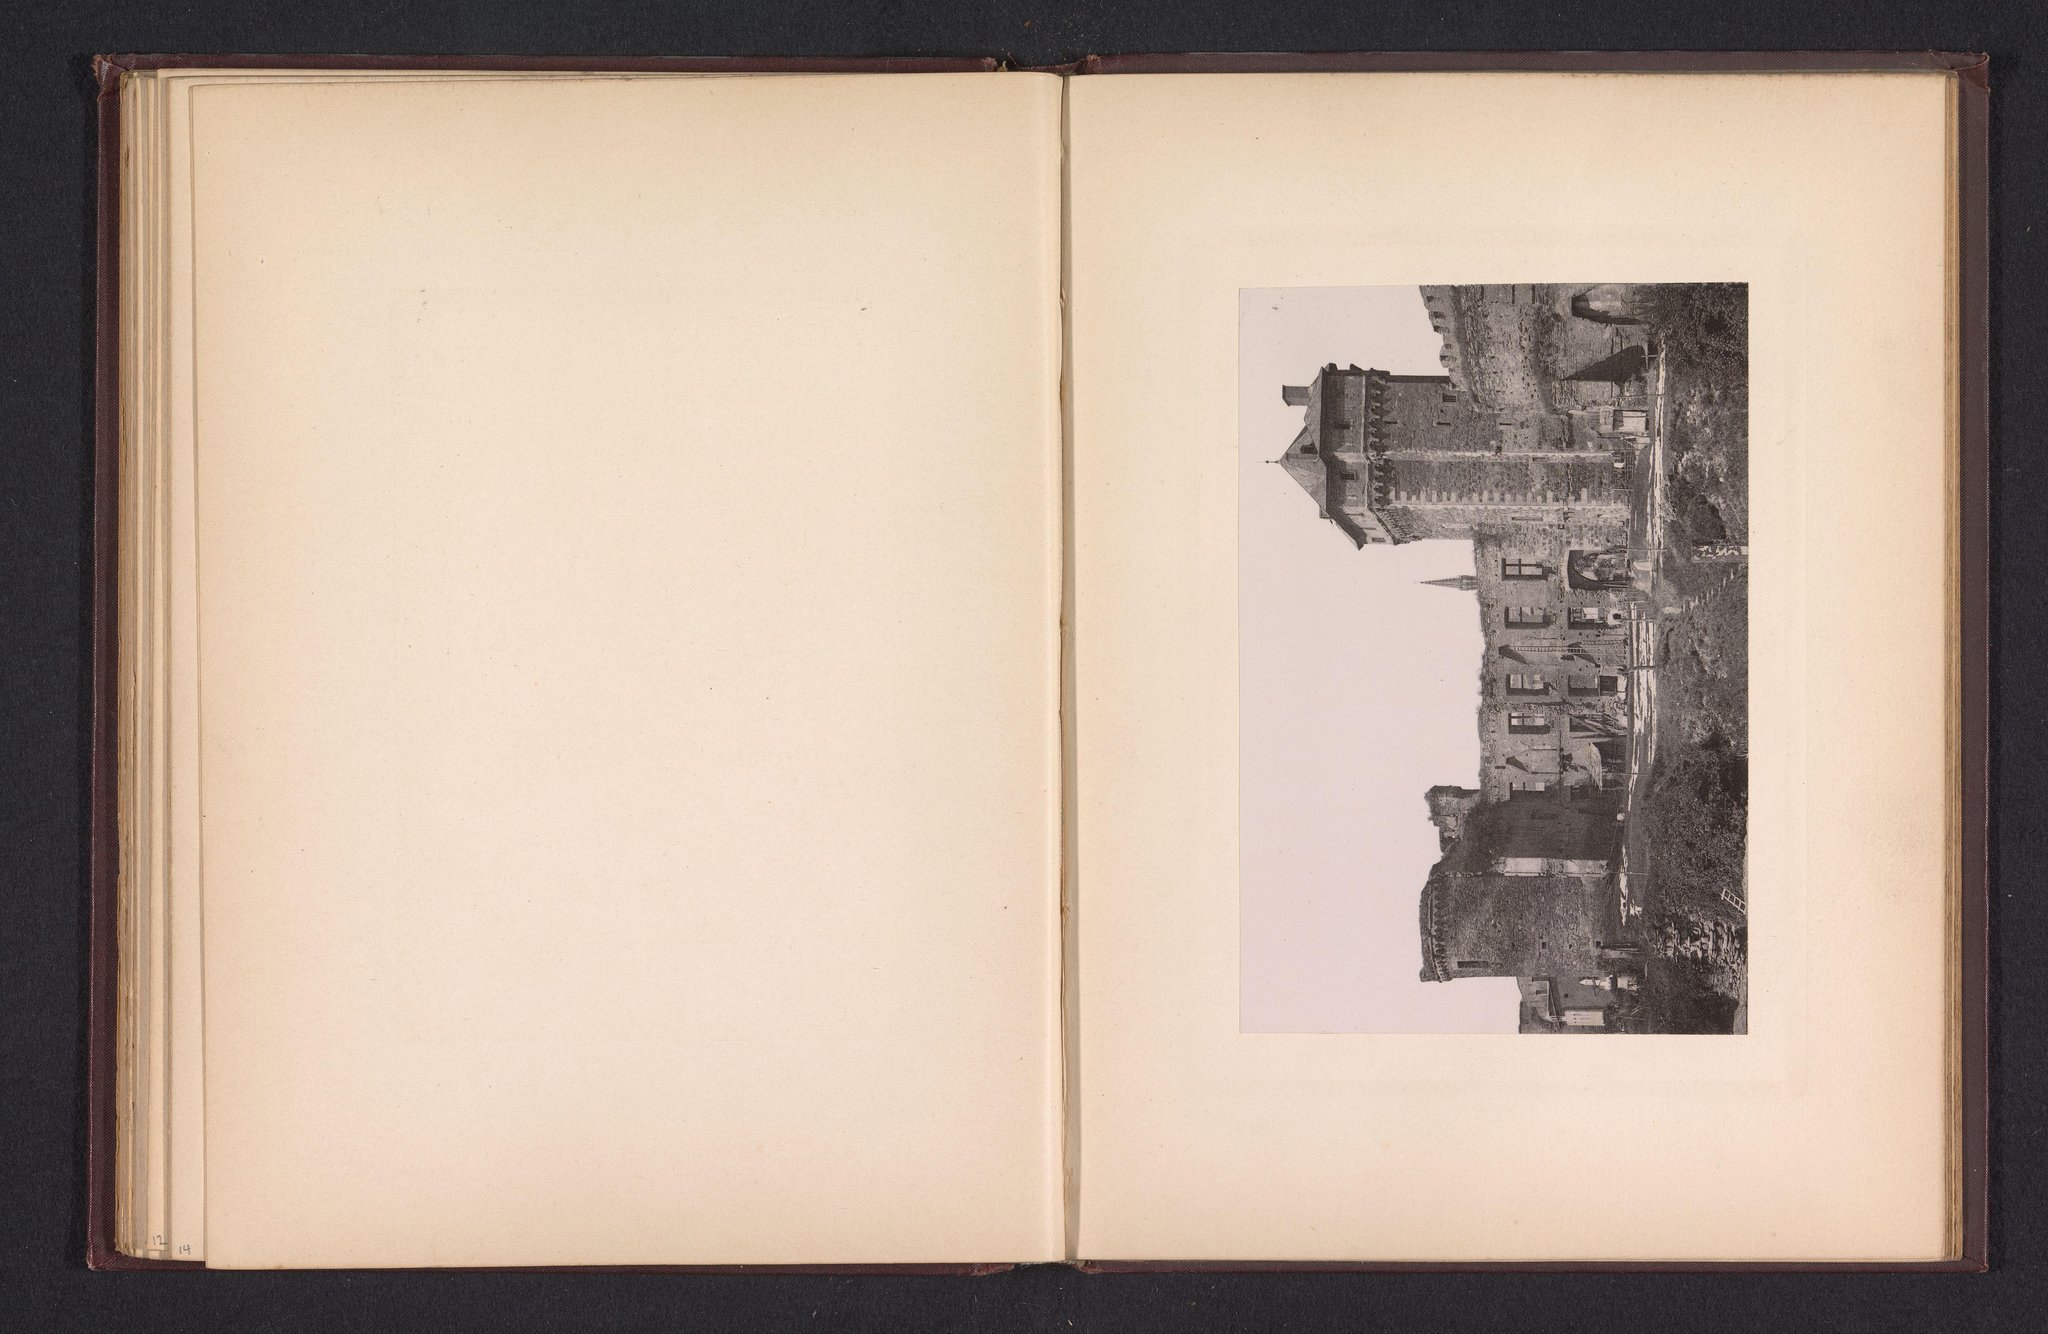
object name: photomechanical print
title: Gezicht op de oude stadsmuren van Andernach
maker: Anonymous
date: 1881-1891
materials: paper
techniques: photograph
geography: andernach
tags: city-walls